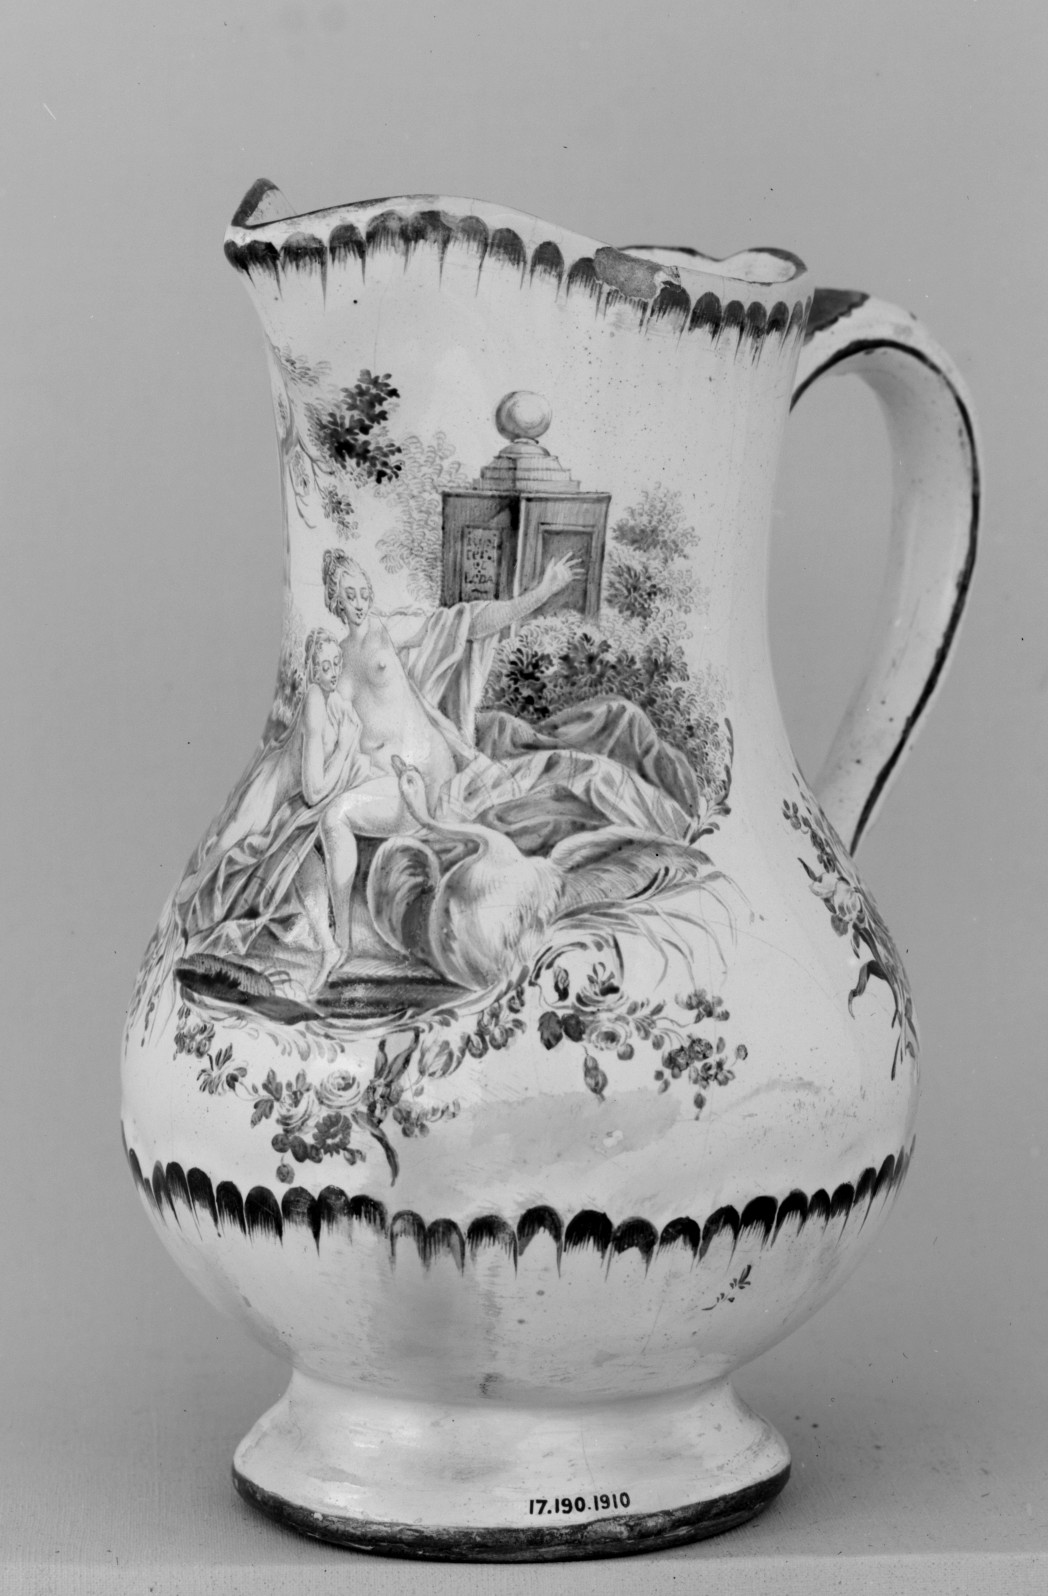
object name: water jug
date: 1753-1795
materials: faience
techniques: glazing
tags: birds,female nudes,flowers,trees